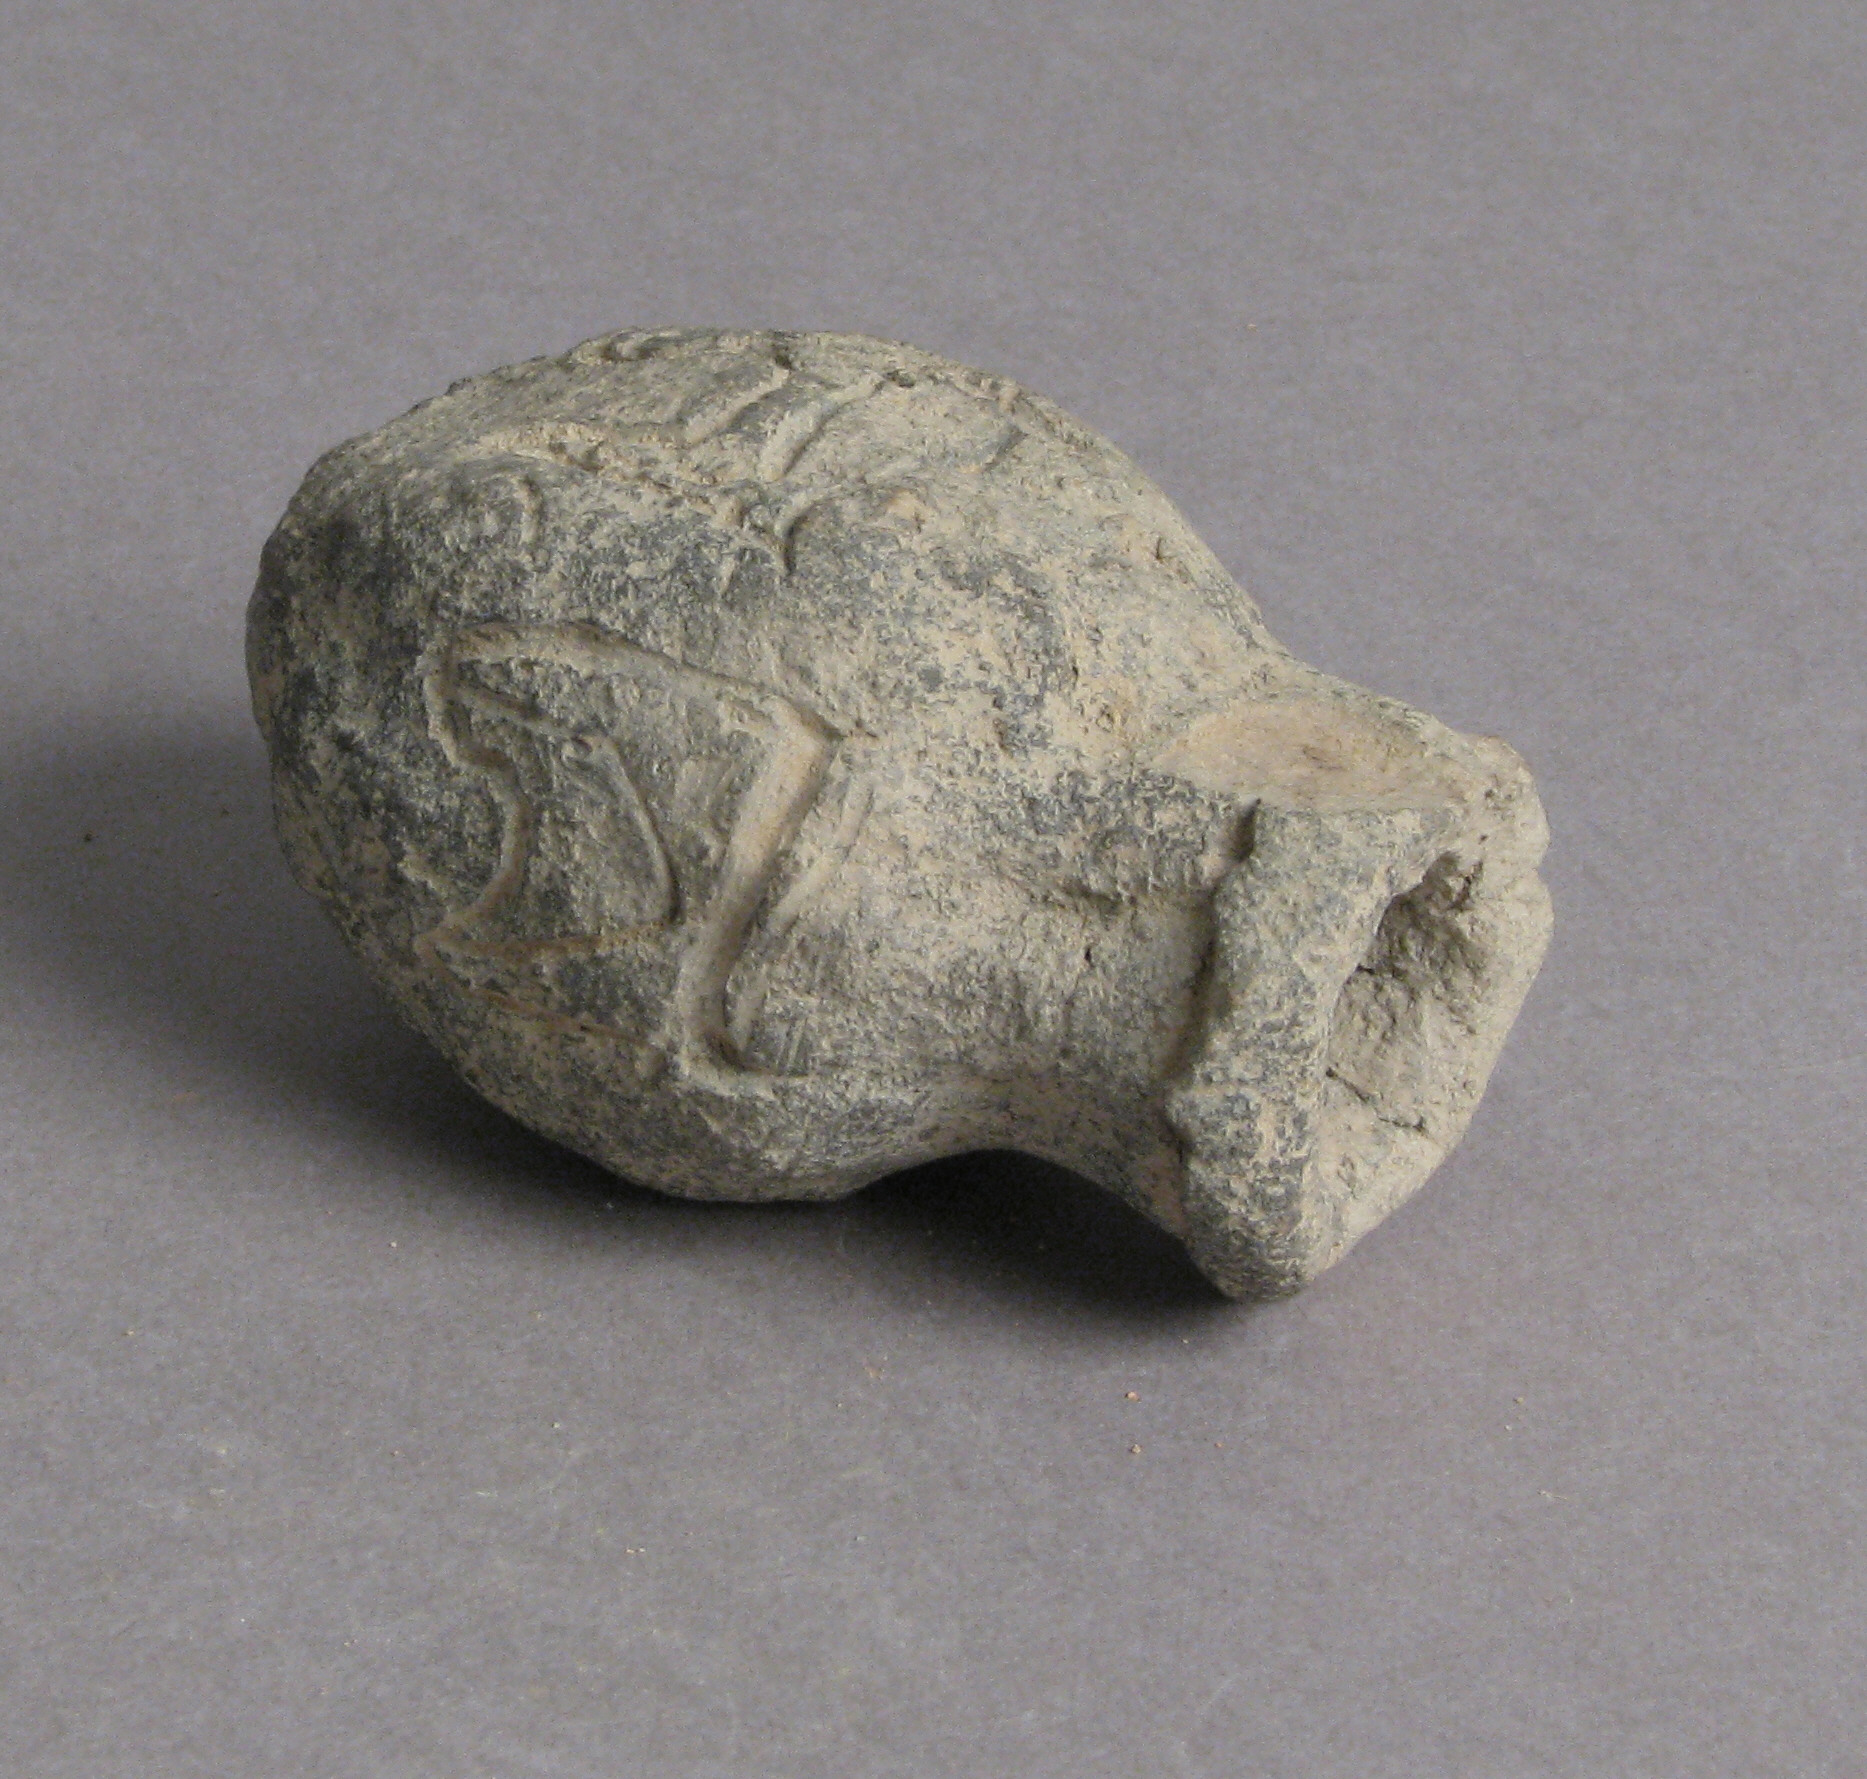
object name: vessel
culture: coptic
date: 301-700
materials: earthenware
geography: egypt